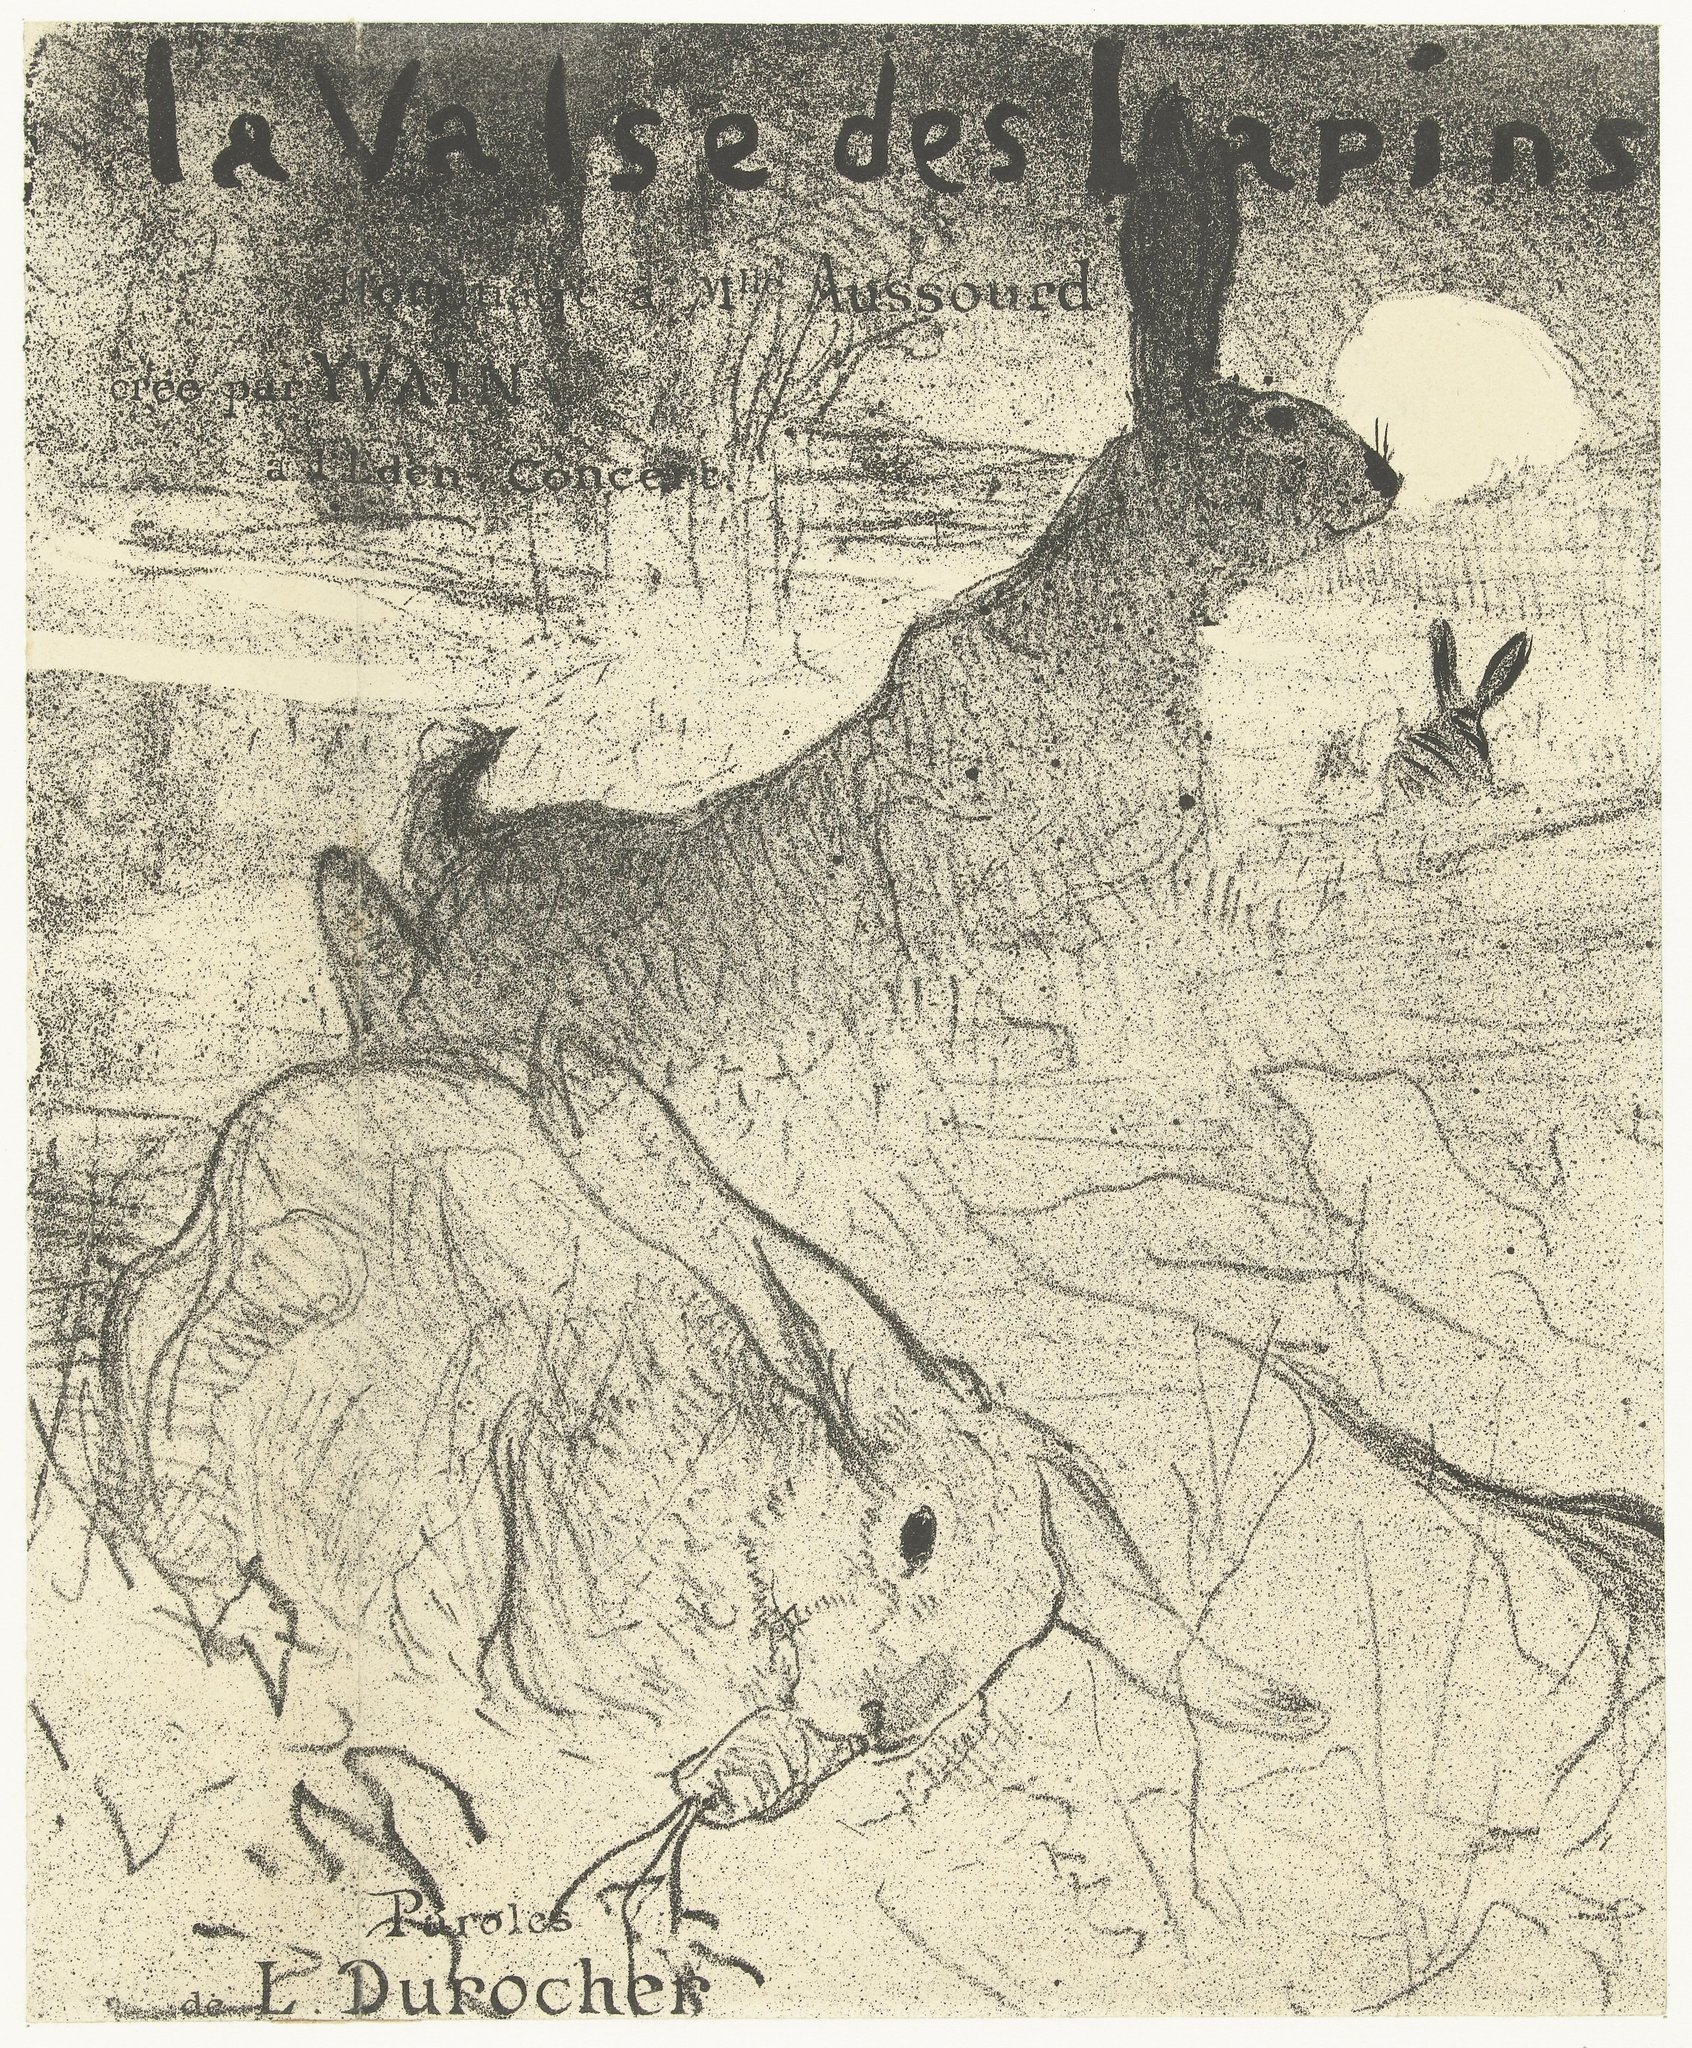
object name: print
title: La Valse des lapins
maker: henri de toulouse-lautrec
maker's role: draughtsman, painter, print maker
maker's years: 1864-1901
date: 1895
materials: paper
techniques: lithograph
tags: rodents: rabbit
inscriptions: collector's mark: Lugt 2228, collector's mark: Lugt 2760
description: Omslag voor een muziekblad met het lied La Valse des Lapins met drie konijnen in een landschap en franse titel. Op het verso staat de muziek van een gedeelte van het lied, de achterflap met de liedtekst ontbreekt.